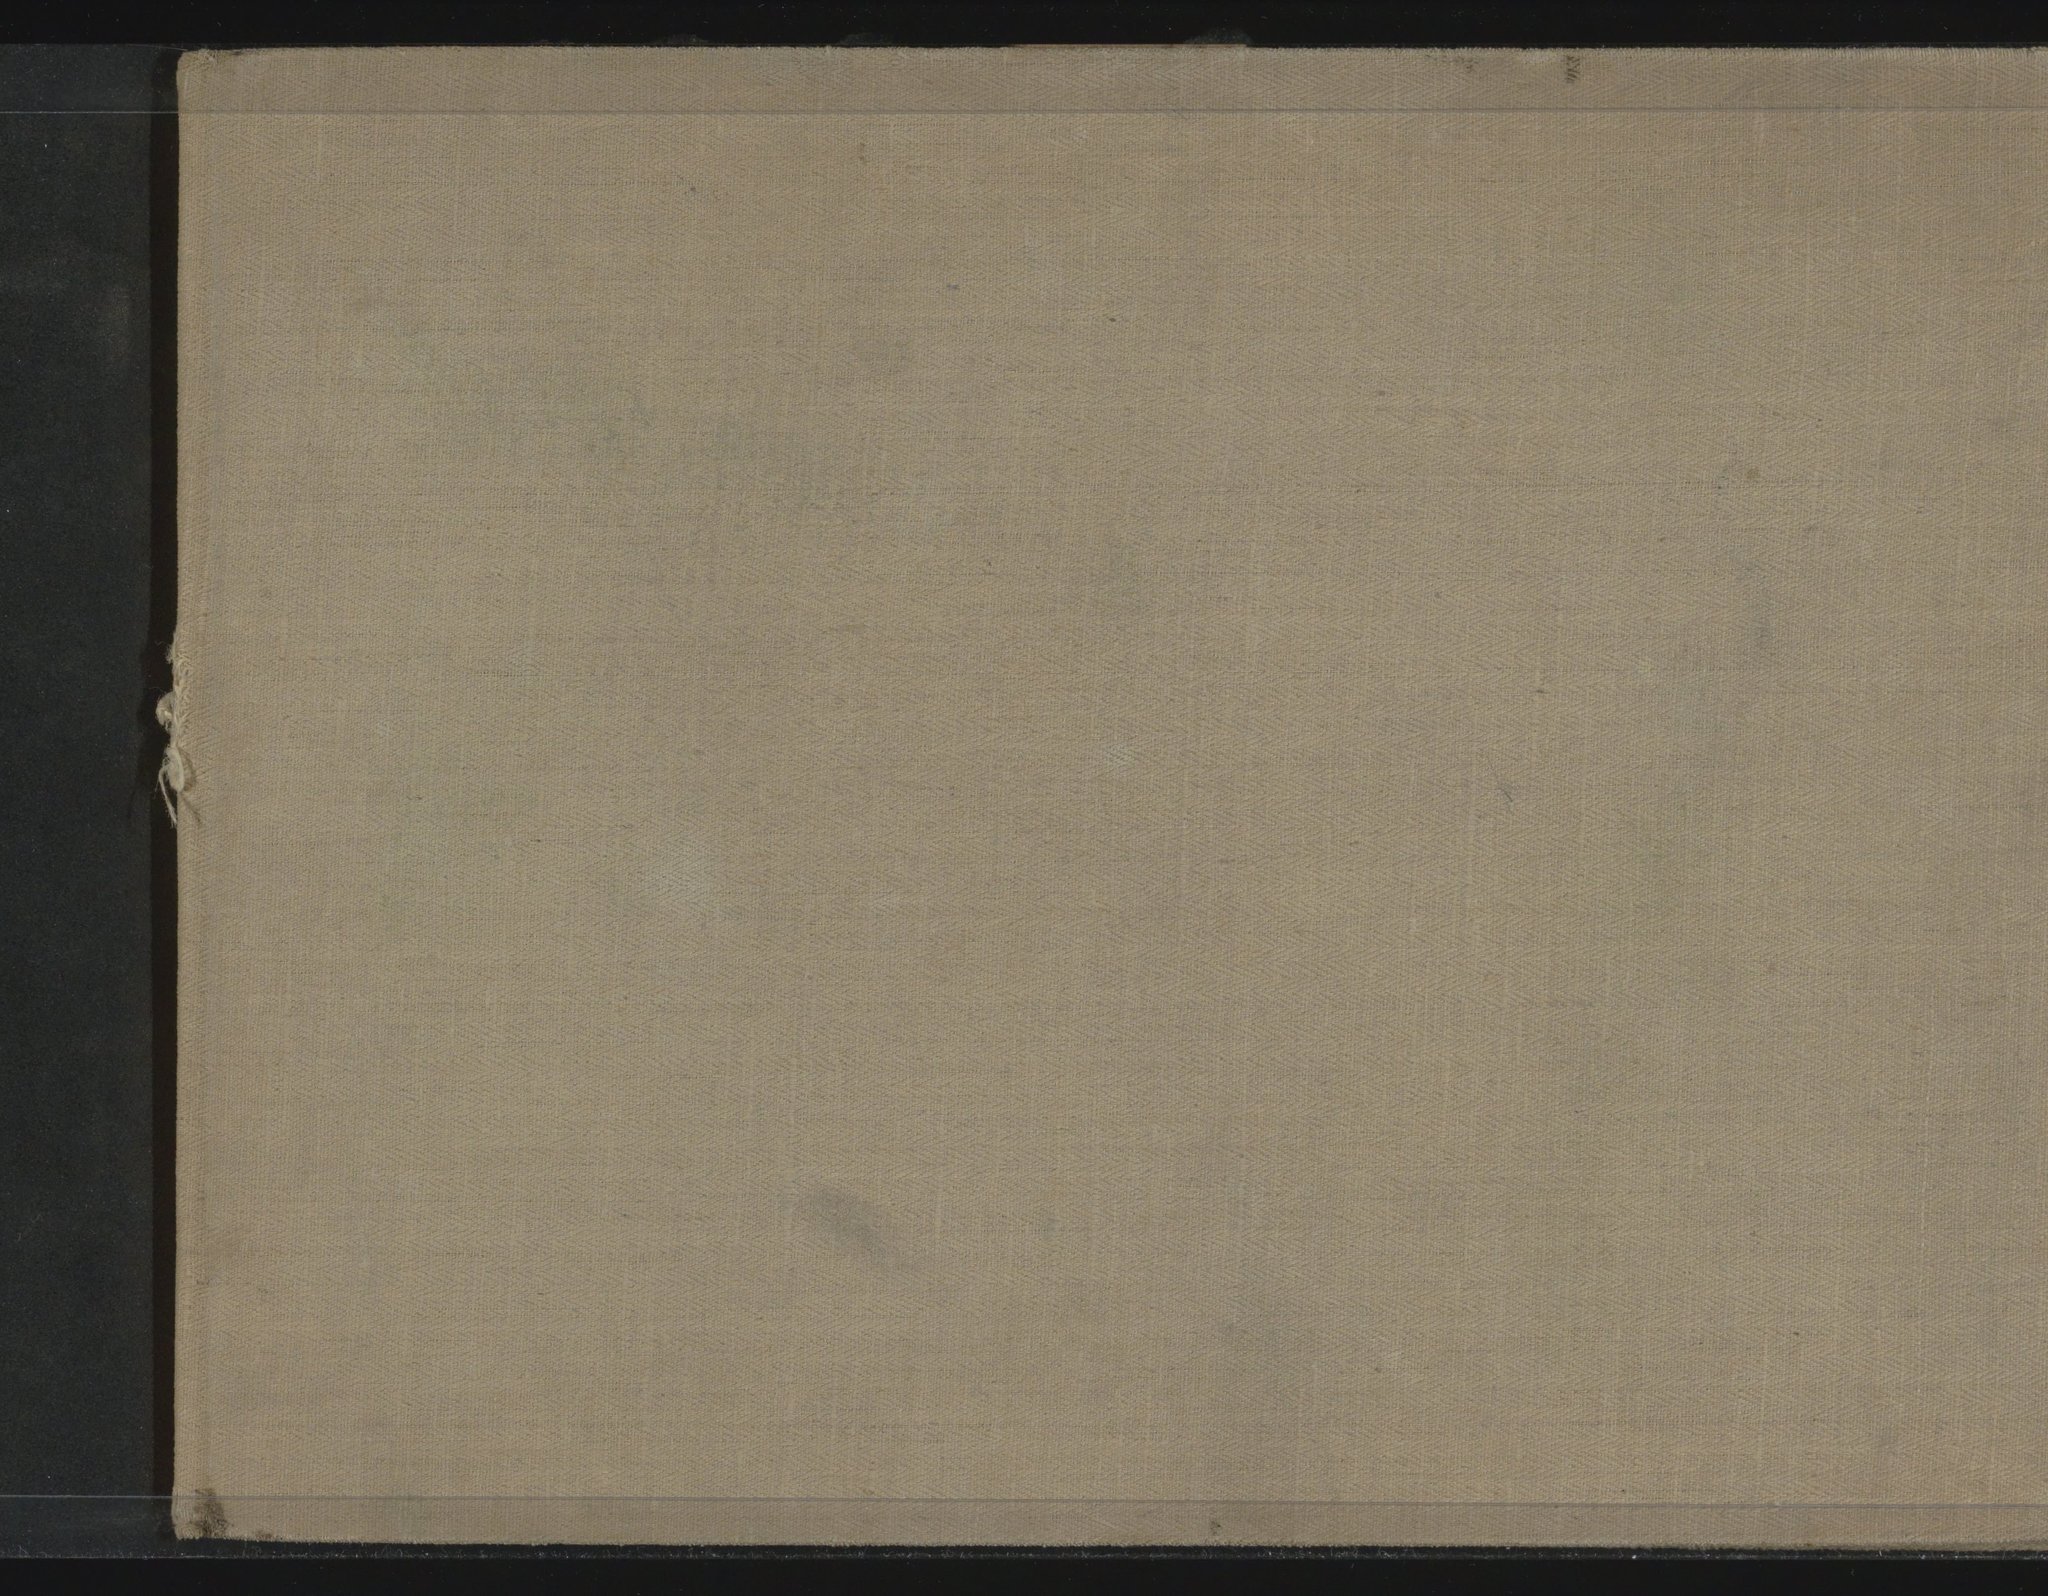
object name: sketchbook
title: Schetsboek met 32 bladen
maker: chris huidekooper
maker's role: draughtsman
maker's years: 1878-1939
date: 1895-1896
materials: cardboard, chalk, ink, linen, paper, pencil, watercolor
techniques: brush, pen, stumping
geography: groningen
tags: landscapes, anatomy (non-medical)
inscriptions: annotation: ‘Lyo/ f 1,45’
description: Op het voorste schutblad van het schetsboek is een krantenartikel geplakt over de herdenkingstentoonstelling van werken van Chris Huidekooper in het Stedelijk Museum te Amsterdam in 1940. Tevens worden bij het schetsboek twee documenten over de verwerving van het schetsboek bewaard. Bij de nummering van de bladen in het schetsboek ontbreken nummers 2, 3, 8, 9, 11 t/m 13, 17, 18 en 30. De volgende bladen uit het schetsboek zijn blanco: 4(V), 6(V), 7(V), 9(V), 10(V), 14(V), 15(V), 16(V), 20(V), 21(V), 22(V), 23(V), 26(V), 27(V), 28(V), 31 en 32(V).